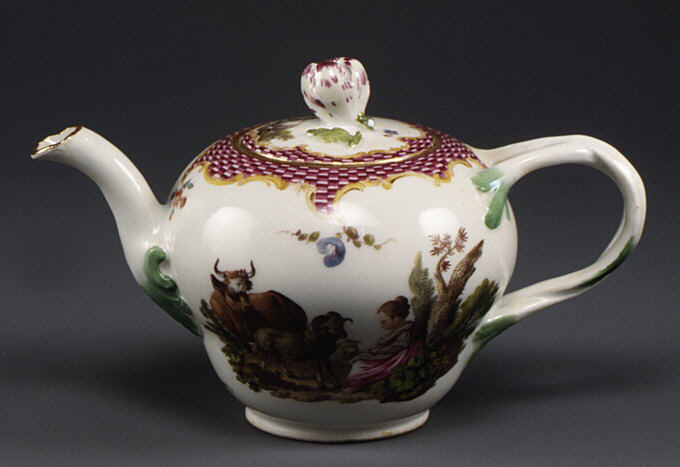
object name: teapot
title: Teapot (part of a set)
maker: meissen manufactory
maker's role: manufactory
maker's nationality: german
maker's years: 1710-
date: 1765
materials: hard paste porcelain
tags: women,bulls,goats,trees